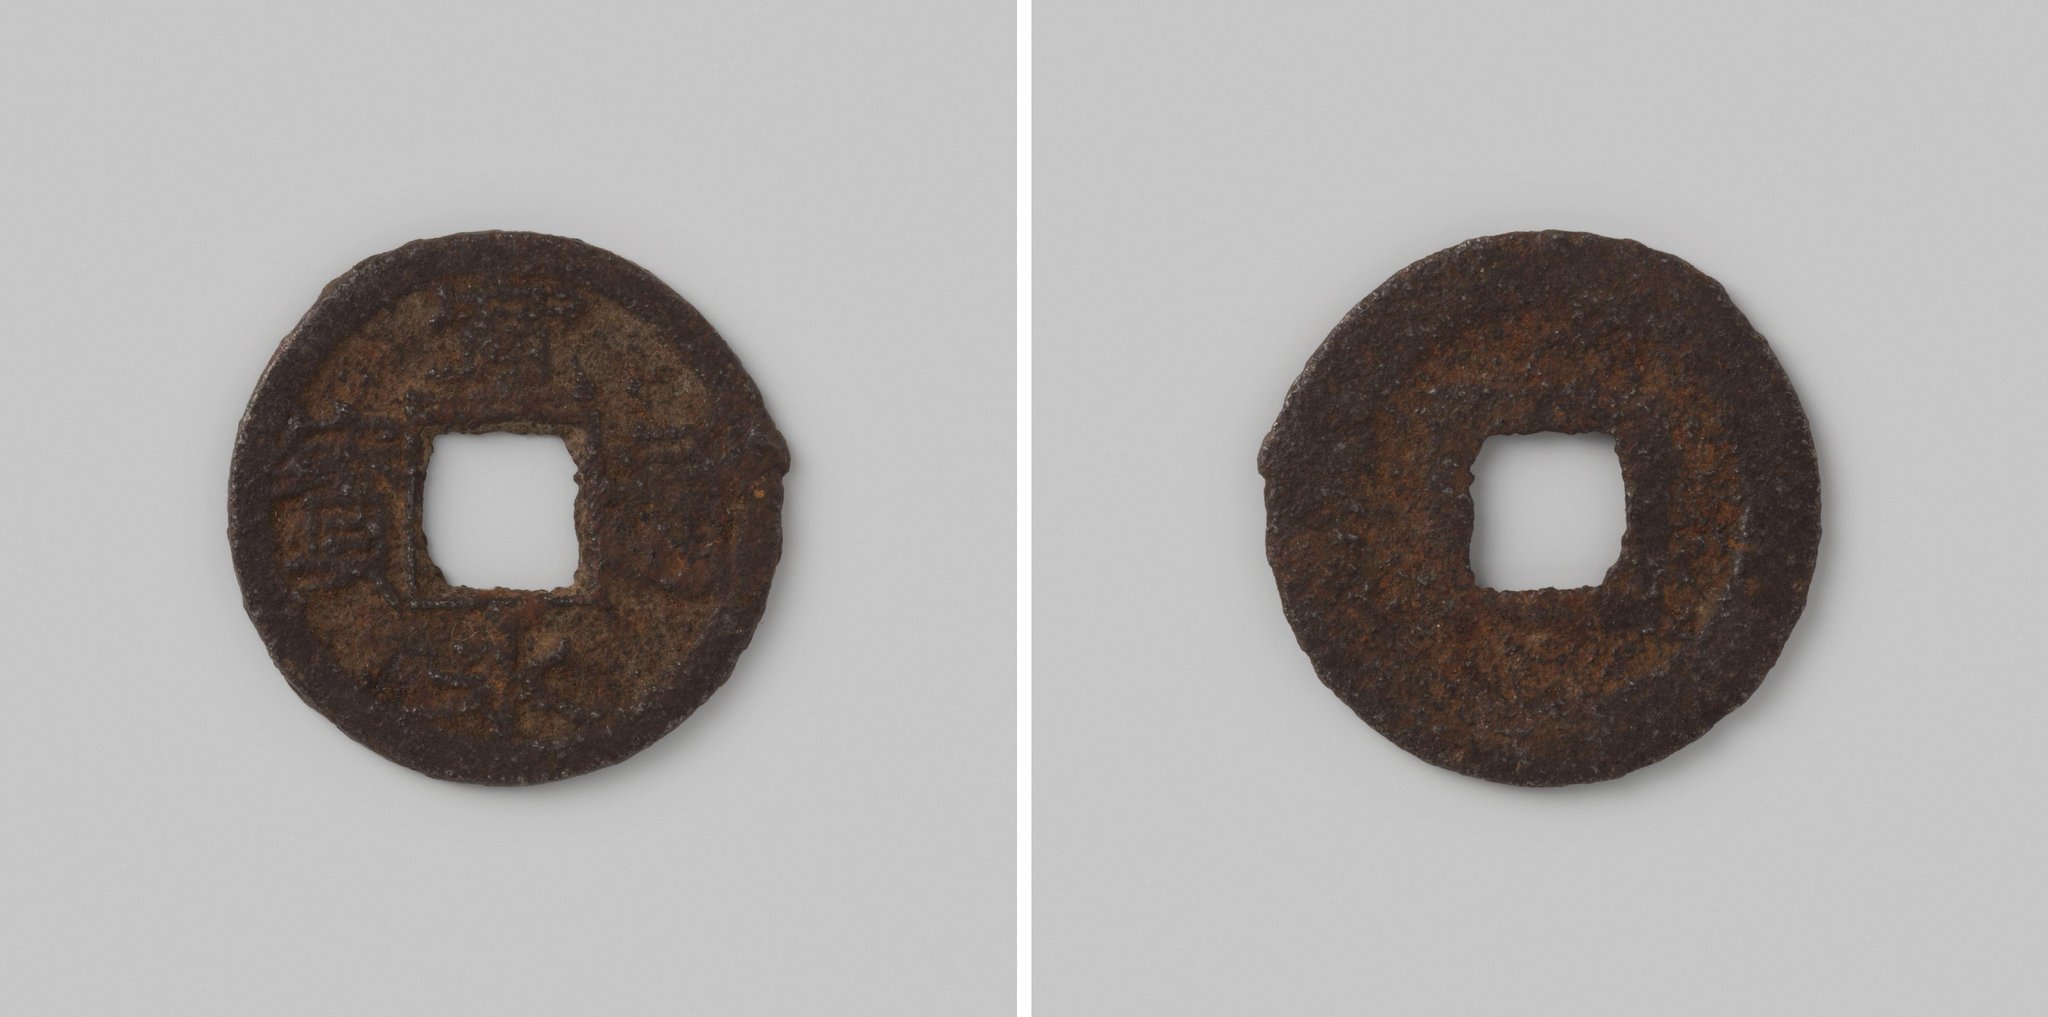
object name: mon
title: Sen van 1 mon uit het keizerrijk Japan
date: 1739-1868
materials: iron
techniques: casting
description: IJzeren munt. Voorzijde: binnen brede gladde rand rondom vierkante uitsparing in het midden vier kruisgewijze geplaatste tekens met de betekenis: kanei tsuho [= kanei periode]. Keerzijde: binnen brde gladde rand glad oppervlak??